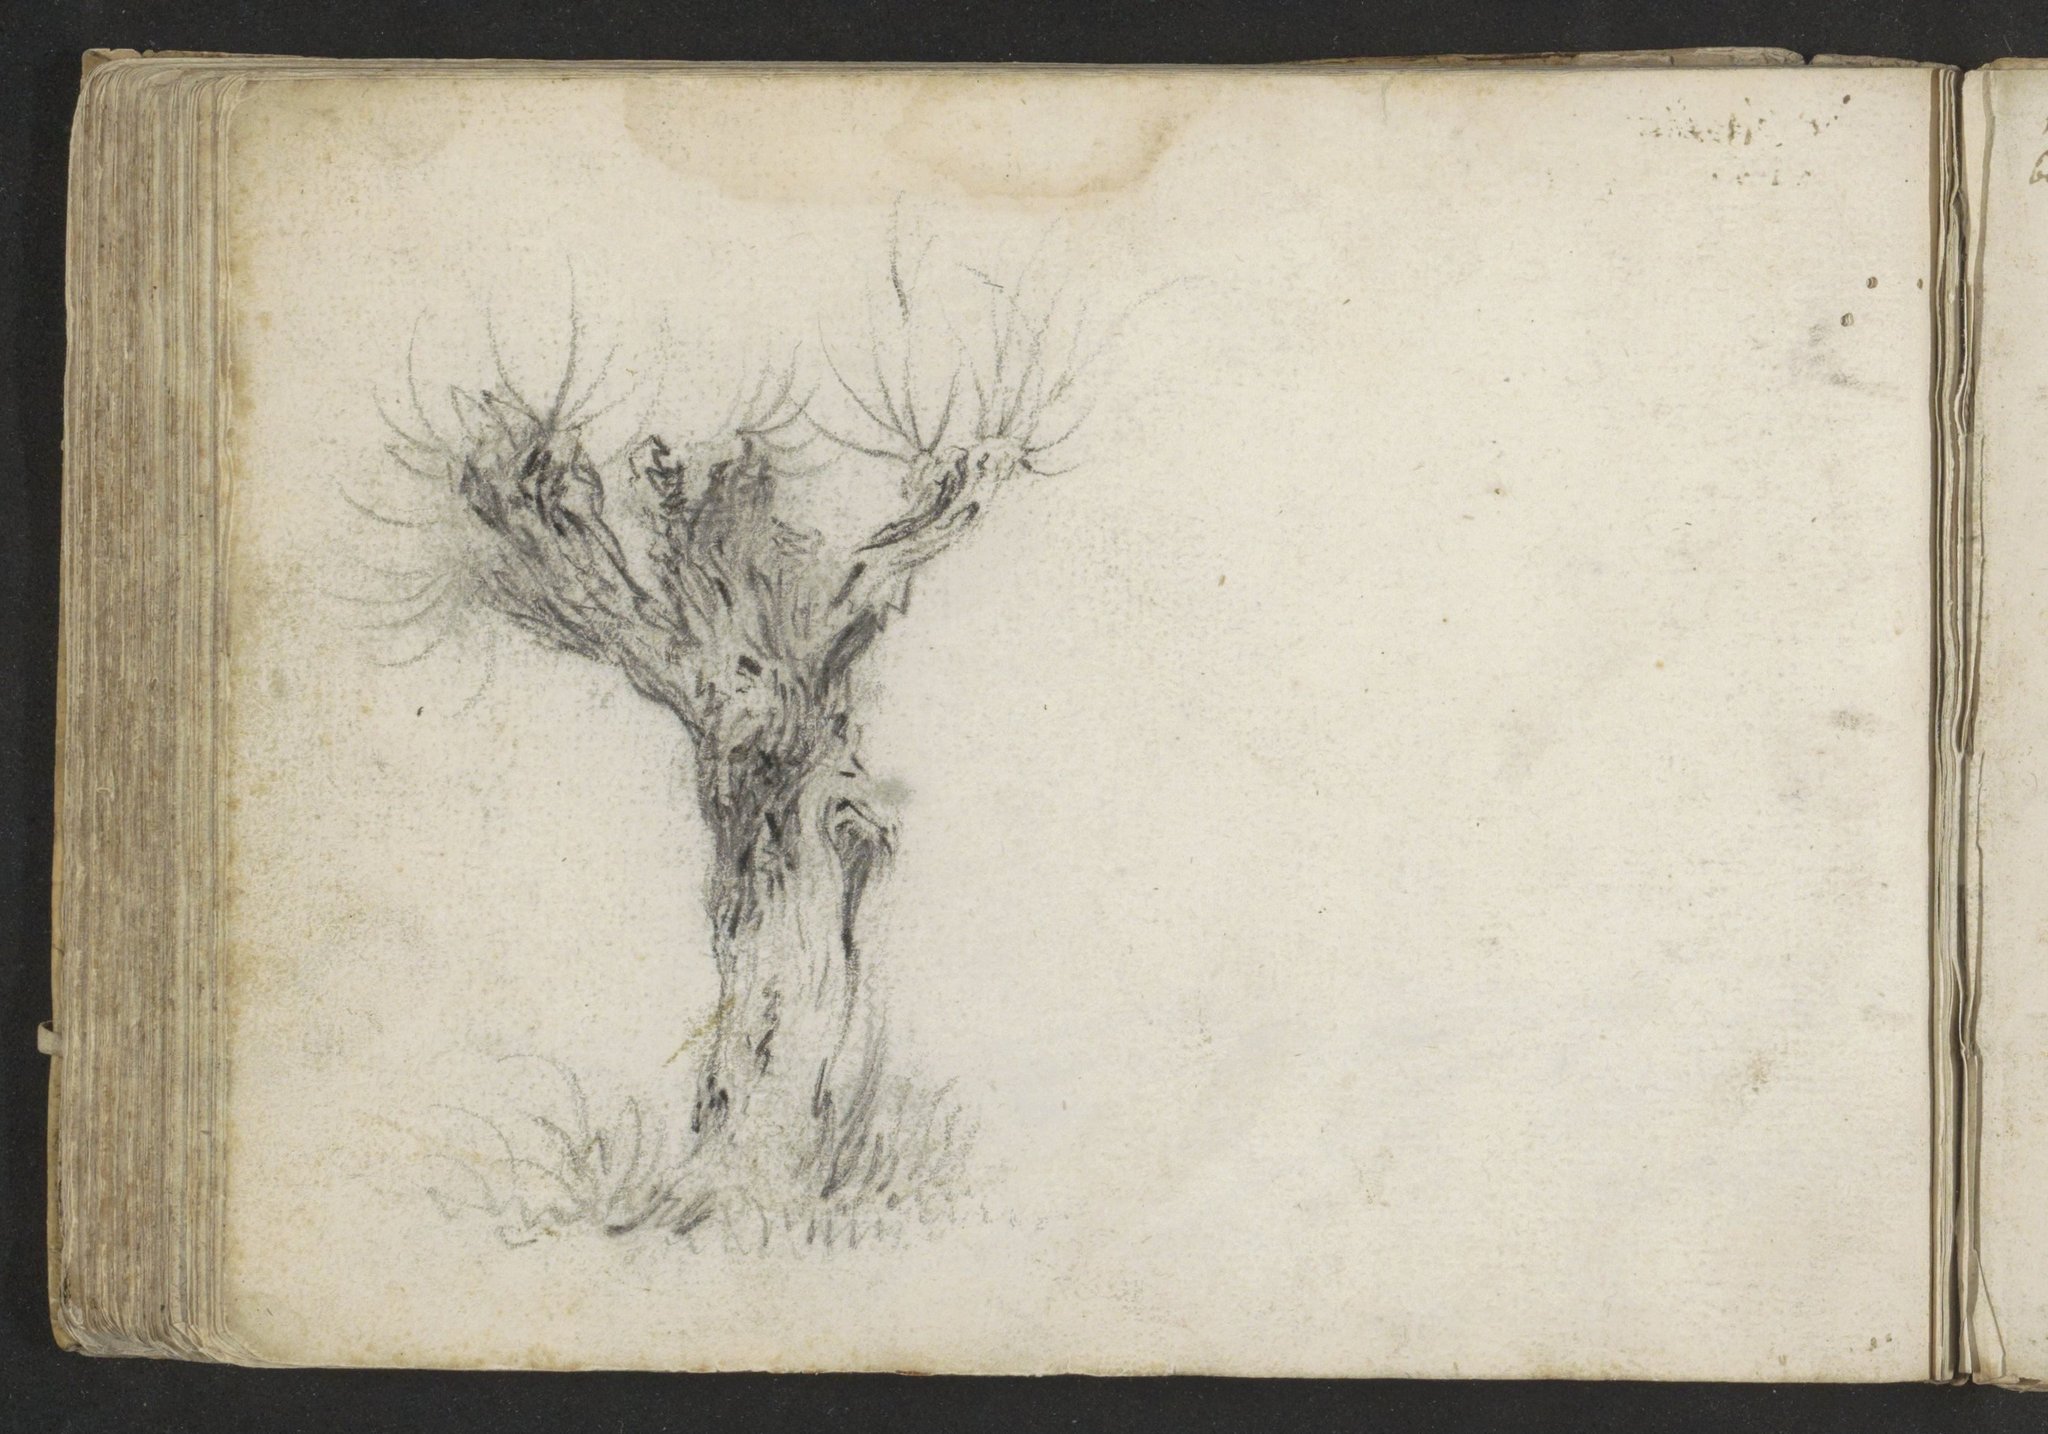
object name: sketchbook leaf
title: Knotwilg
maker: gerard ter borch (ii)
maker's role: draughtsman, painter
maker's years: 1617-1681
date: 1634-1635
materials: chalk, paper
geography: haarlem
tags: trees: willow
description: Blad 55 verso uit een schetsboek met 55 bladen.